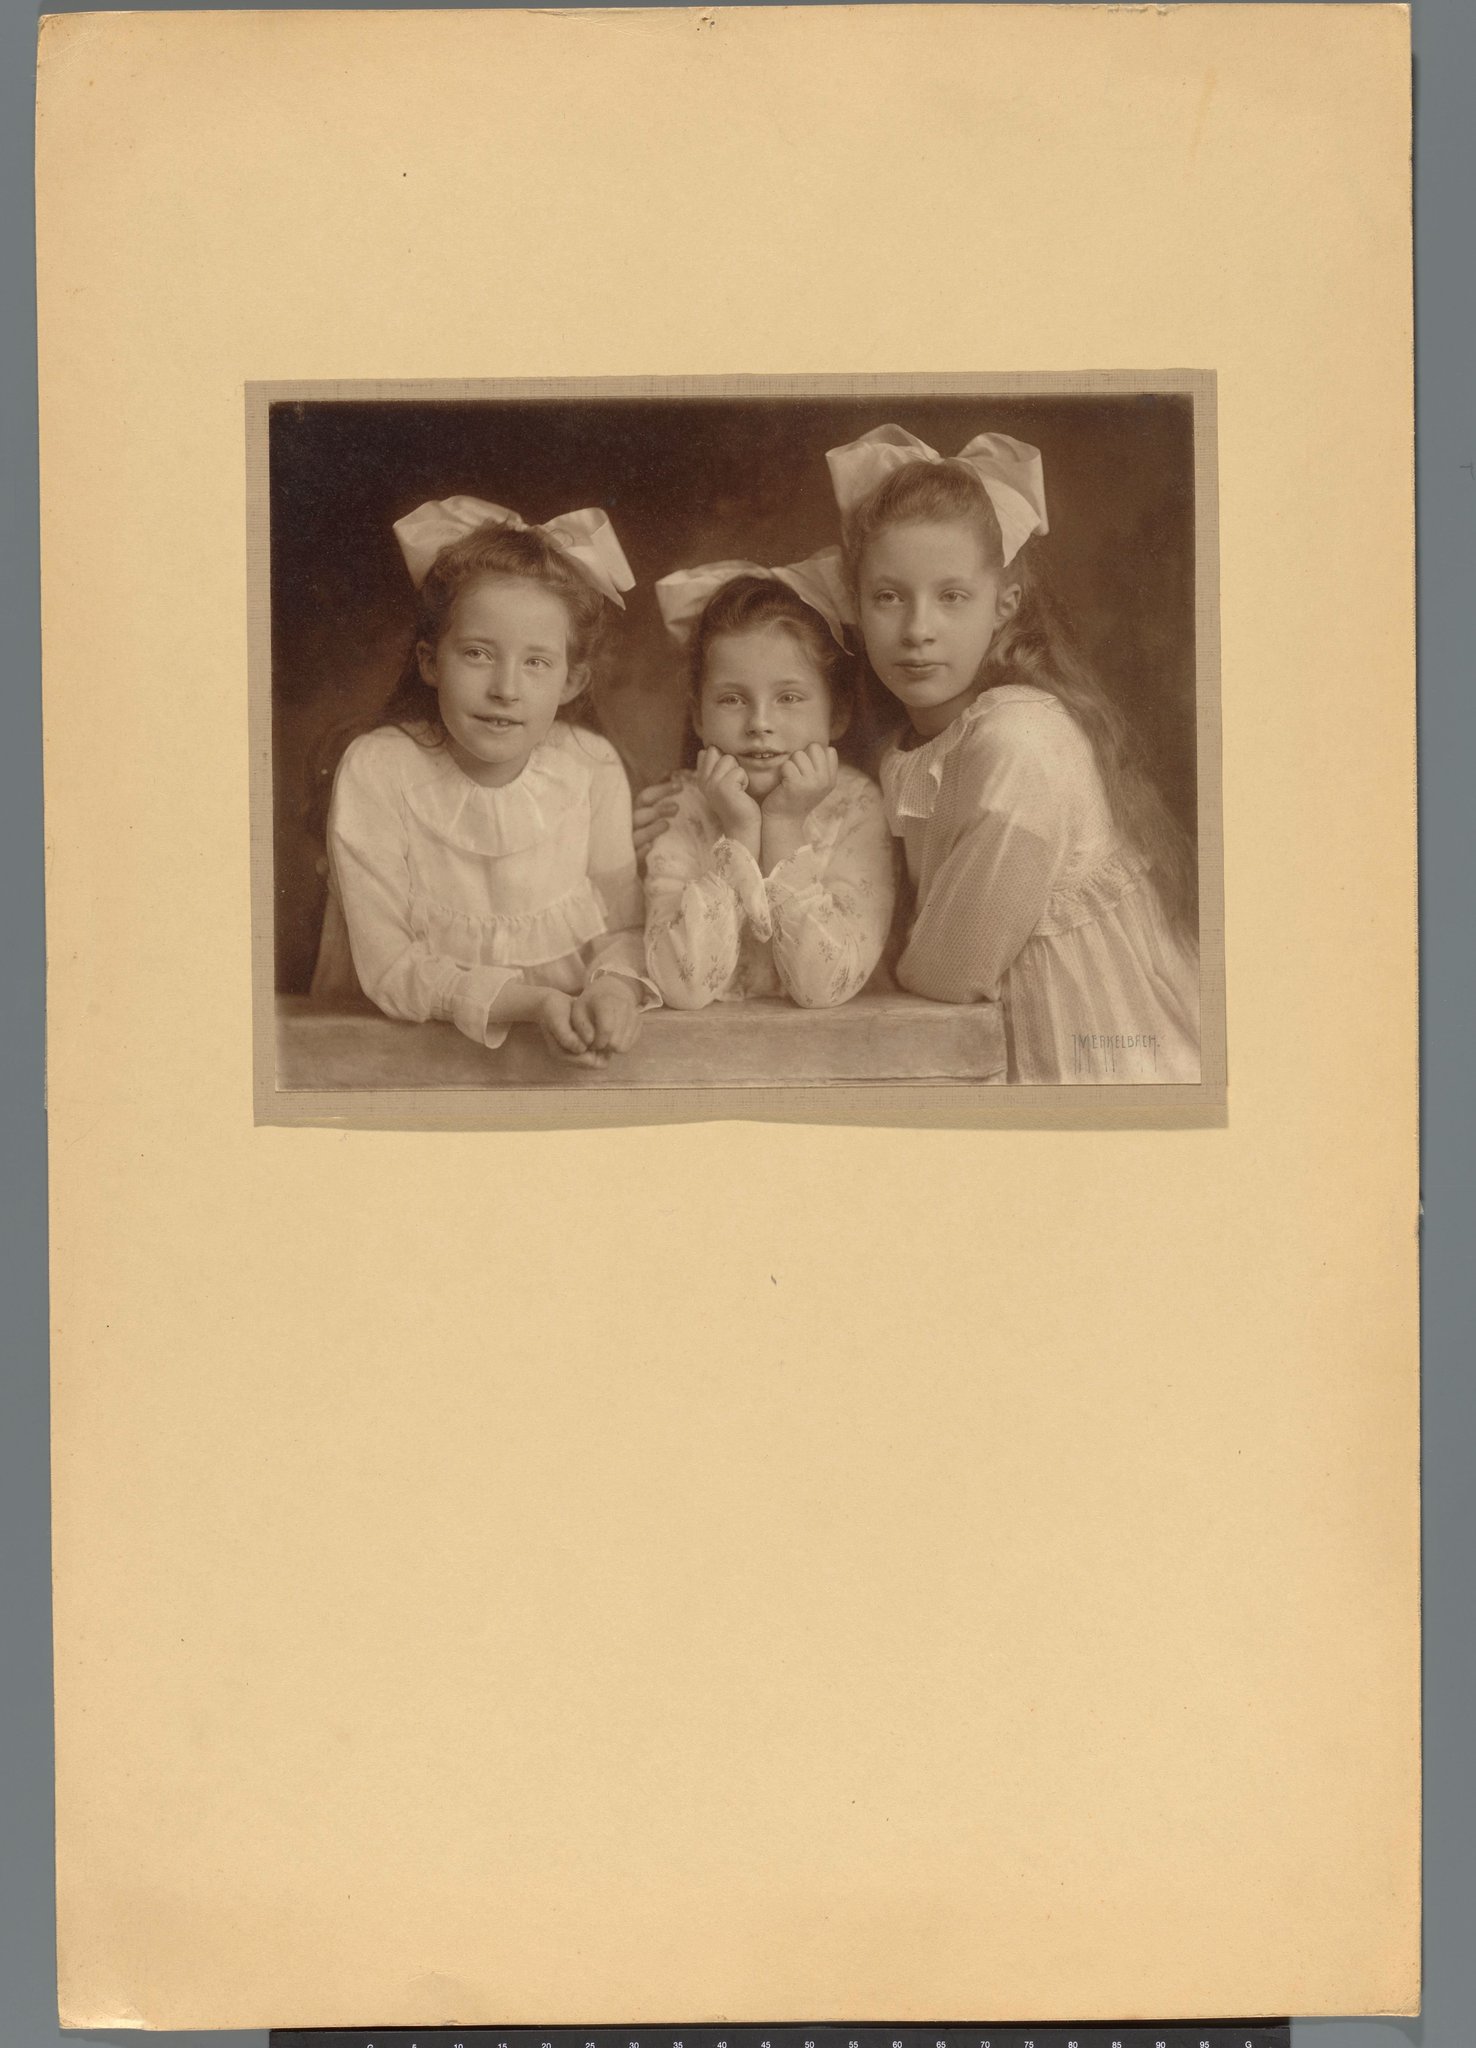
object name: photograph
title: Portret van drie meisjes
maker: jacob merkelbach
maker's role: fotograaf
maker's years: 1877-1942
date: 1910-1930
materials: cardboard, paper, photographic support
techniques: collodion silver print, daylight paper print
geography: amsterdam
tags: anonymous historical persons portrayed in a group, in a group-portrait - bb - woman